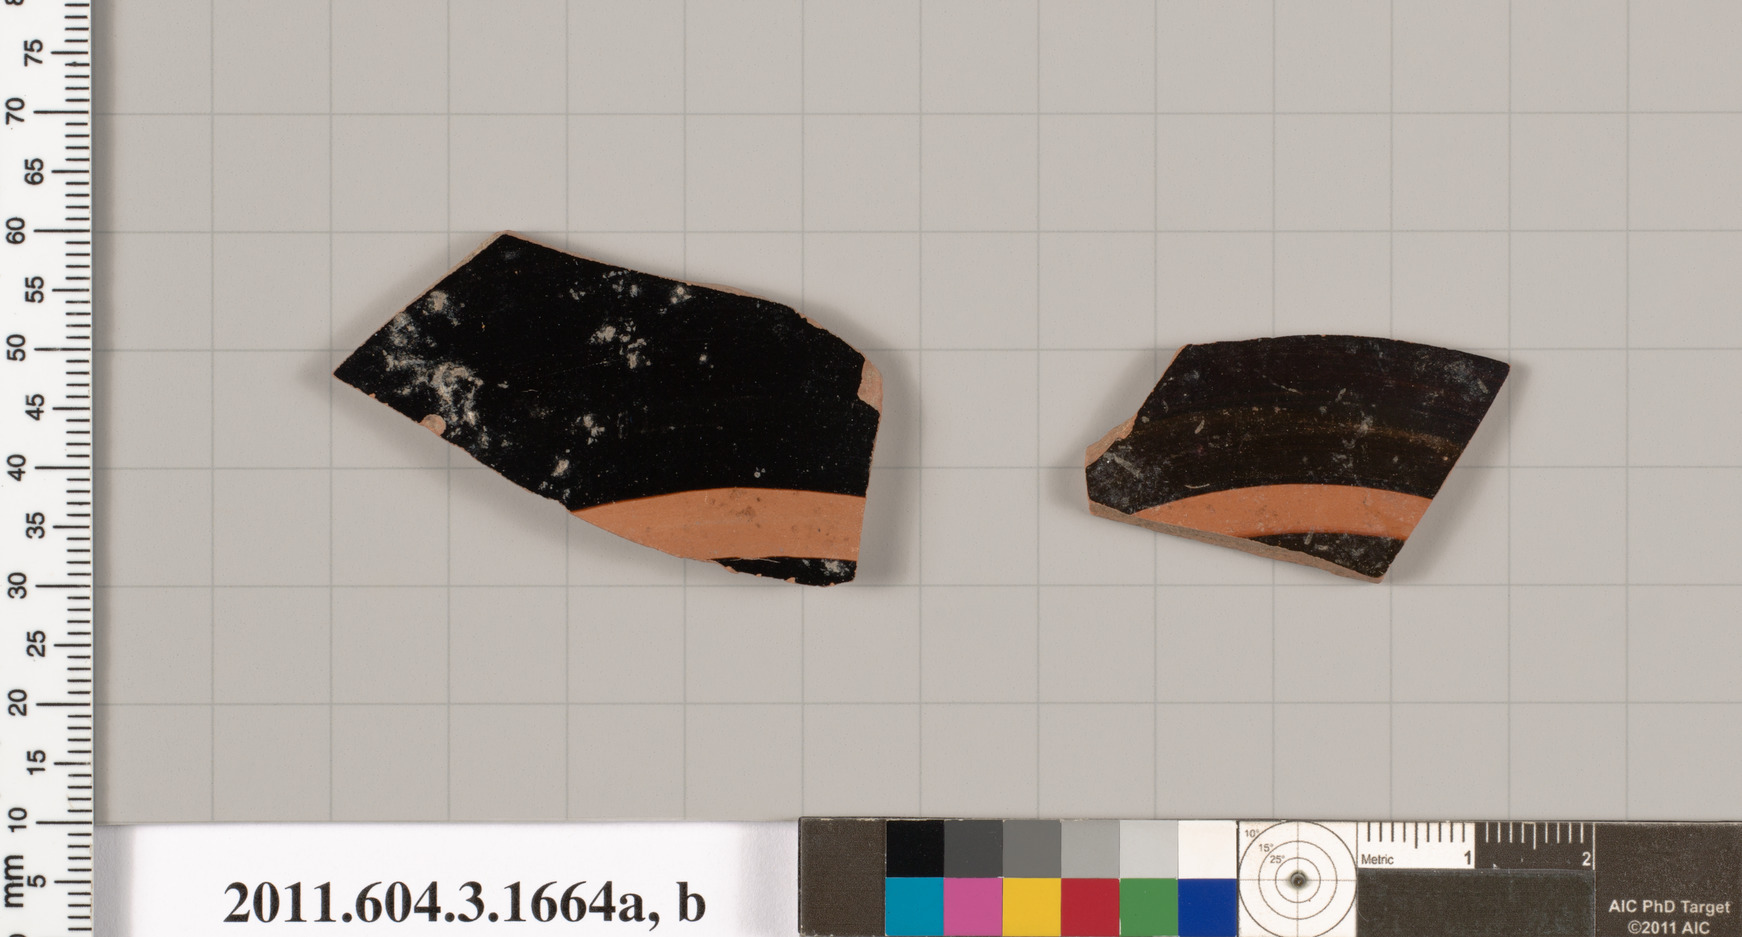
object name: kylix fragment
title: Terracotta fragments of kylikes: Band or lip cups (drinking cups)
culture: greek, attic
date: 550-526 BCE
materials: terracotta